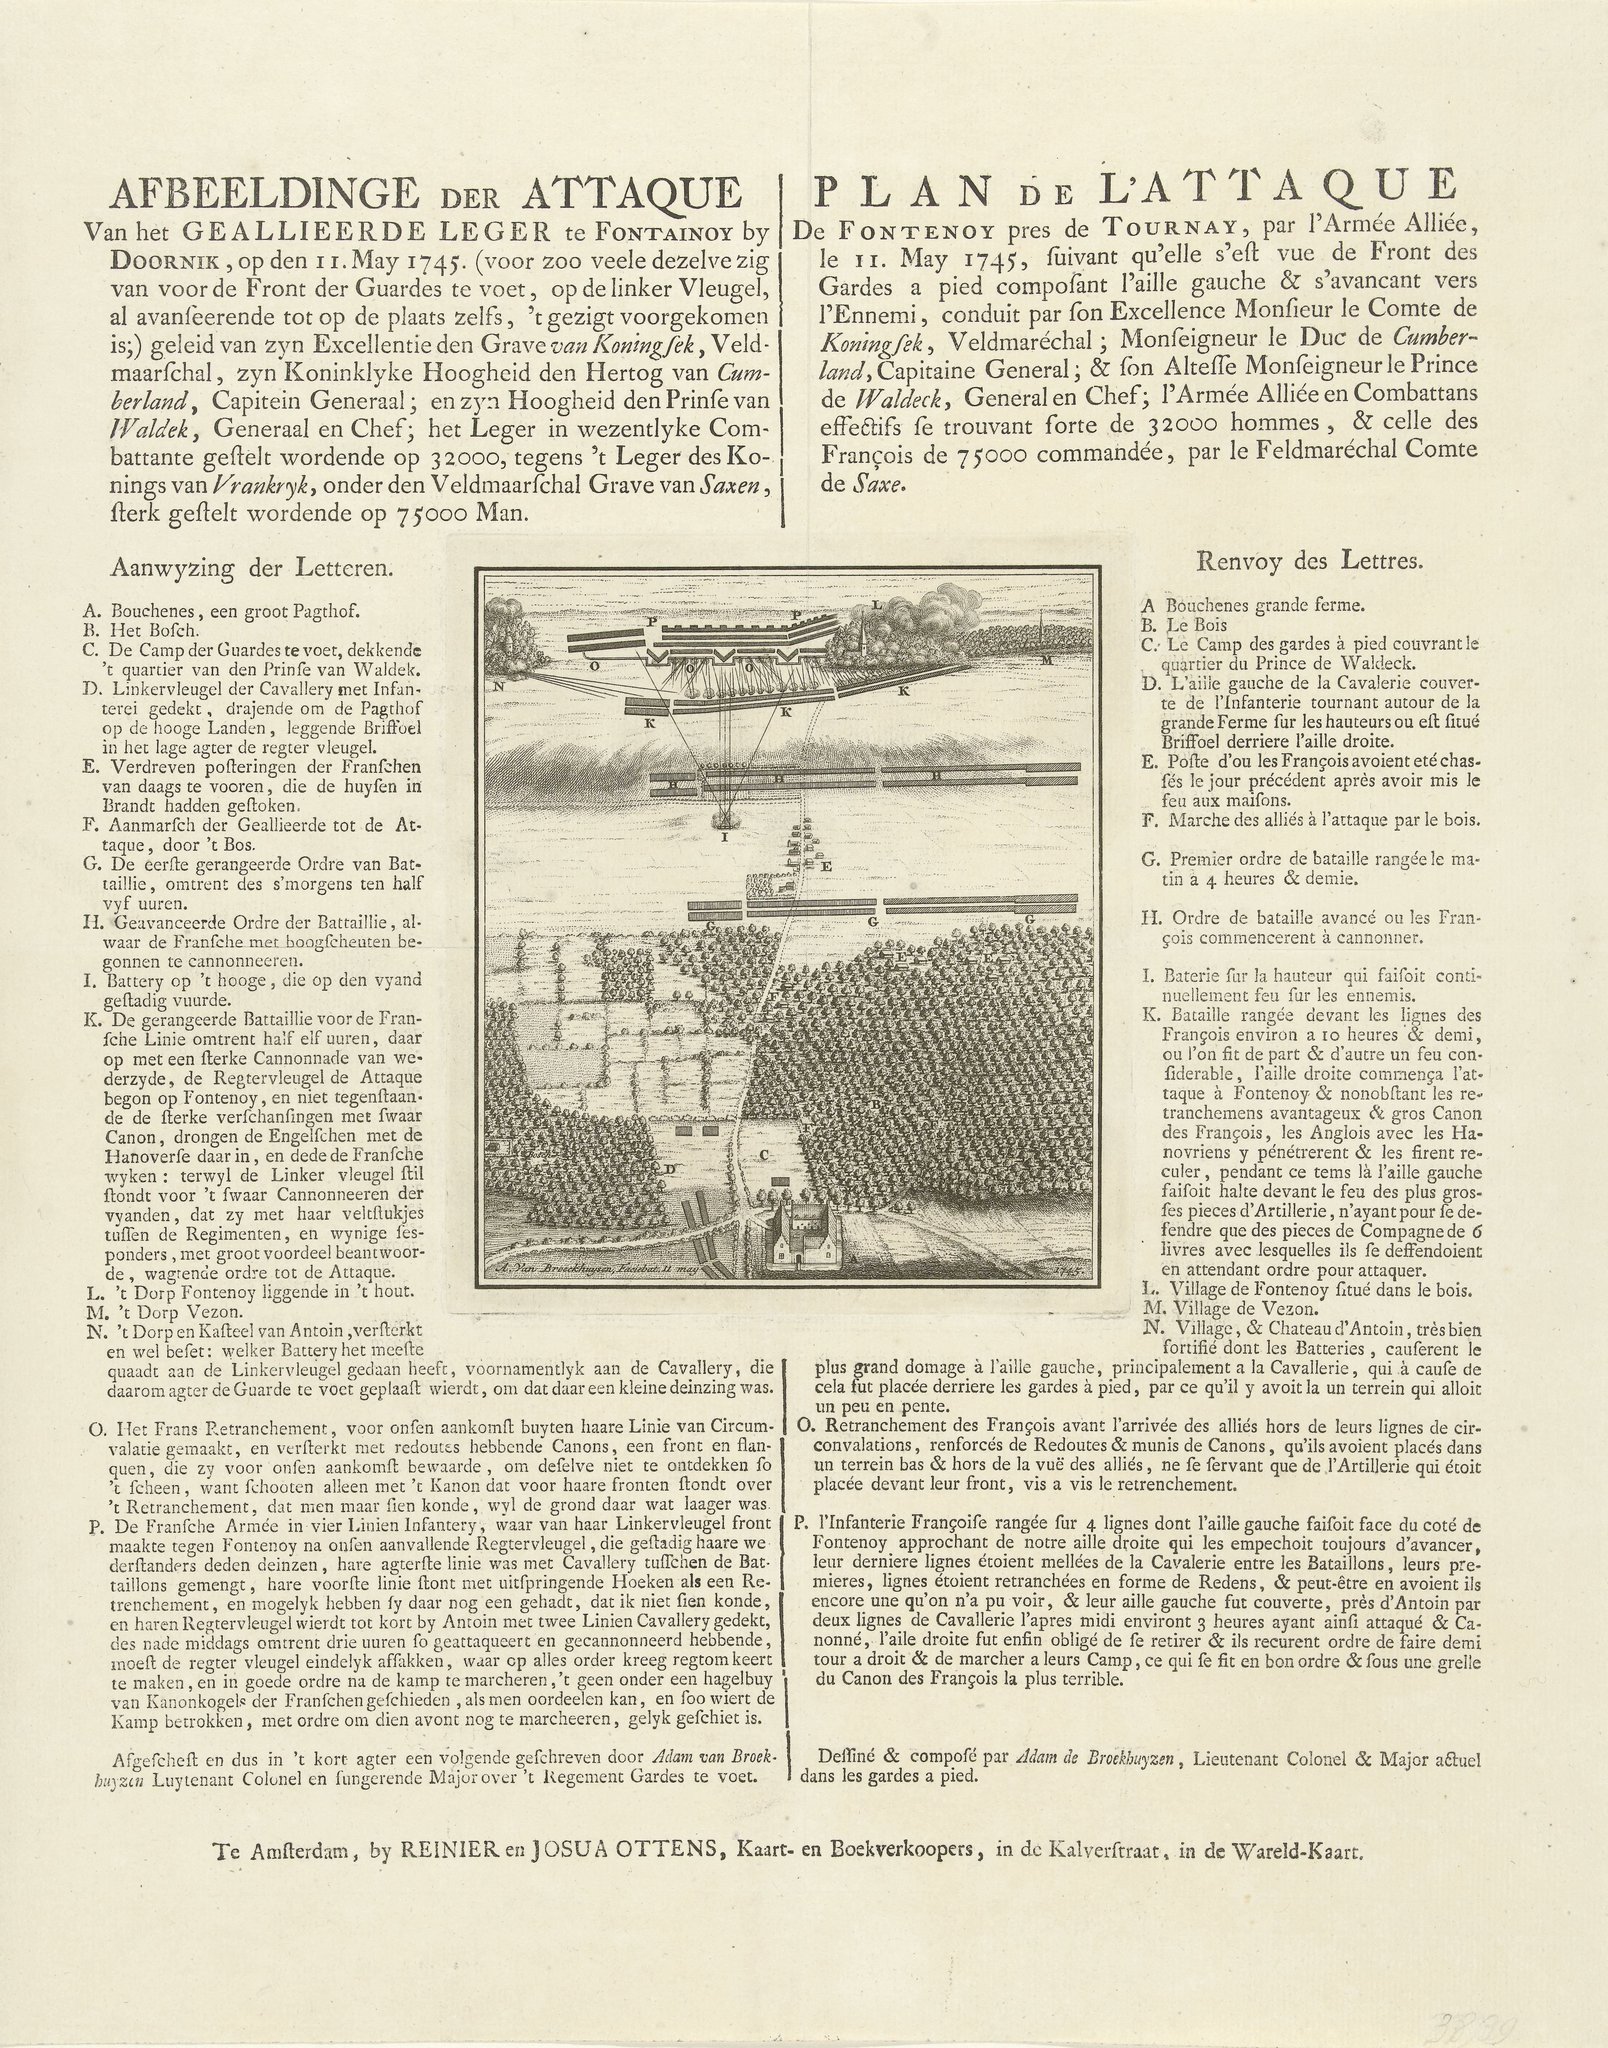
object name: print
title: Plan van de aanval van de Geallieerden in de slag bij Fontenoy, 1745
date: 1745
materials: paper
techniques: engraving, etching, letterpress printing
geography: northern netherlands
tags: battle (+ land forces)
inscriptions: collector's mark: Lugt 2228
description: Plattegrond met de aanval door de Geallieerden in de slag bij Fontenoy (bij Doornik) op 11 mei 1745 tussen het Geallieerde leger en de Fransen. Op het blad boven, naast en onder de plaat een beschrijving en de verklaring van de letters A-P in het Frans en Nederlands.